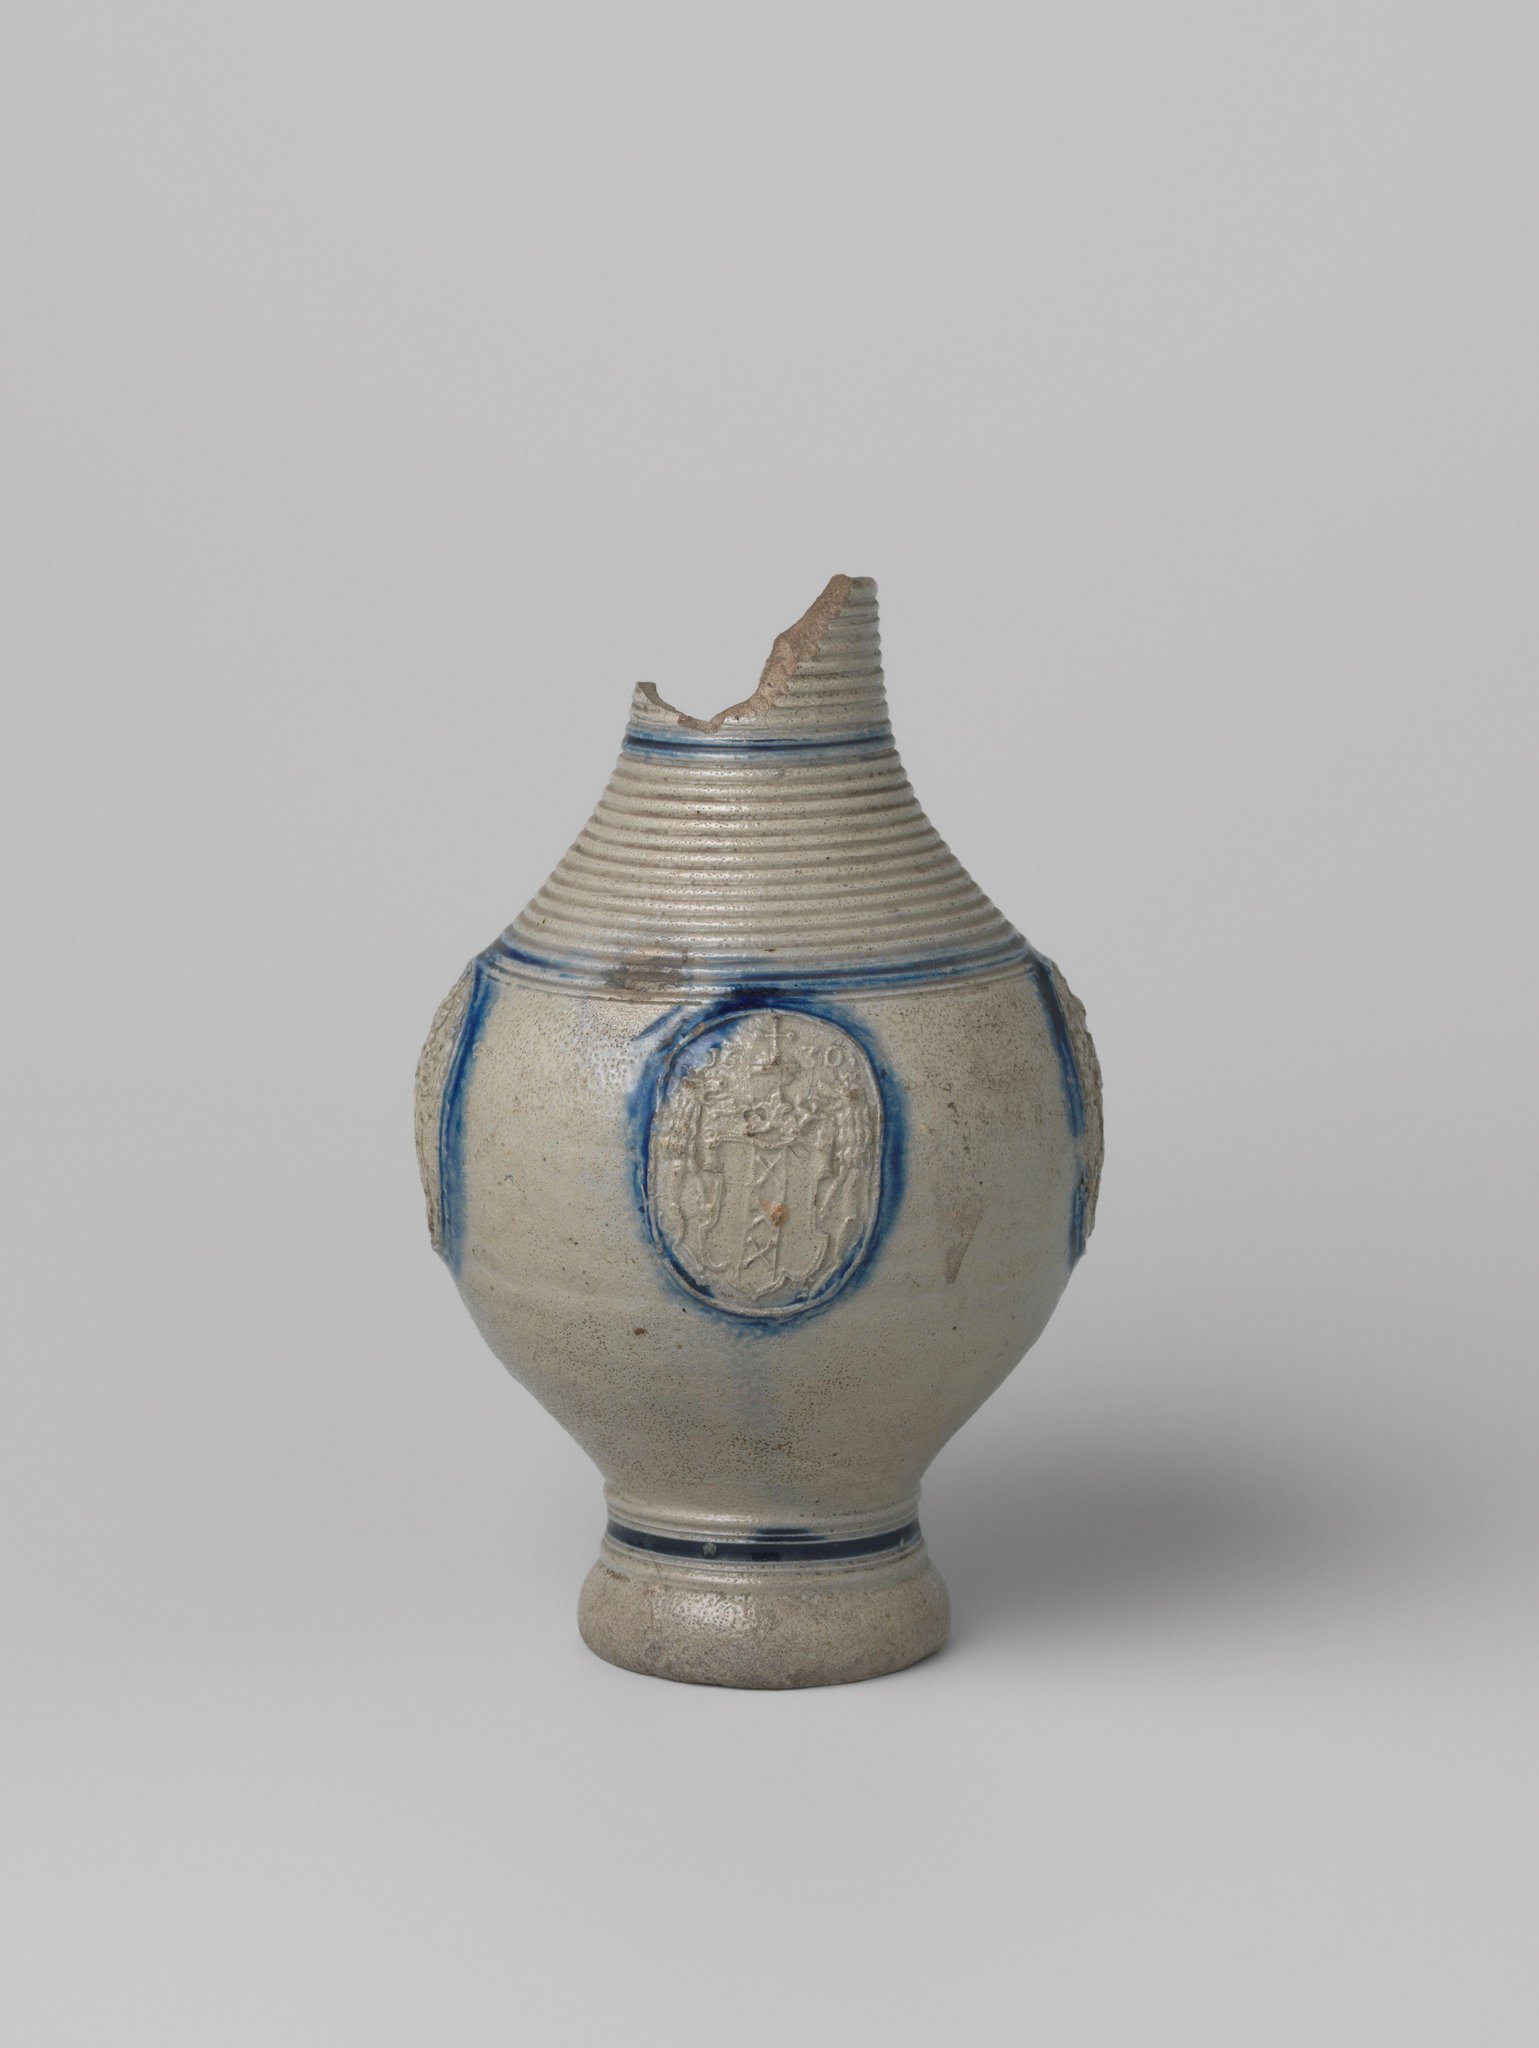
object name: jug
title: Fragment of a jug with the coat of arms of Amsterdam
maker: Anonymous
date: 1630-1649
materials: cobalt, glaze, stoneware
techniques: firing, forming, relief, turning, vitrification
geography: westerwald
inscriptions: date: ‘1630’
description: Fragment van een kruik van steengoed op hoge voet met een eivormig lichaam en een taps toelopende nek. Het oor en een deel van de nek ontbreken. Een brede band met ingegrifte lijnen op de nek, enkele op de voet. Gedeeltelijk bedekt met kobaltblauw. Op de buik driemaal een gedrukt en opgelegd medaillon met het wapen van Amsterdam in reliëf. Op het wapen de datum '1630'. Westerwald.